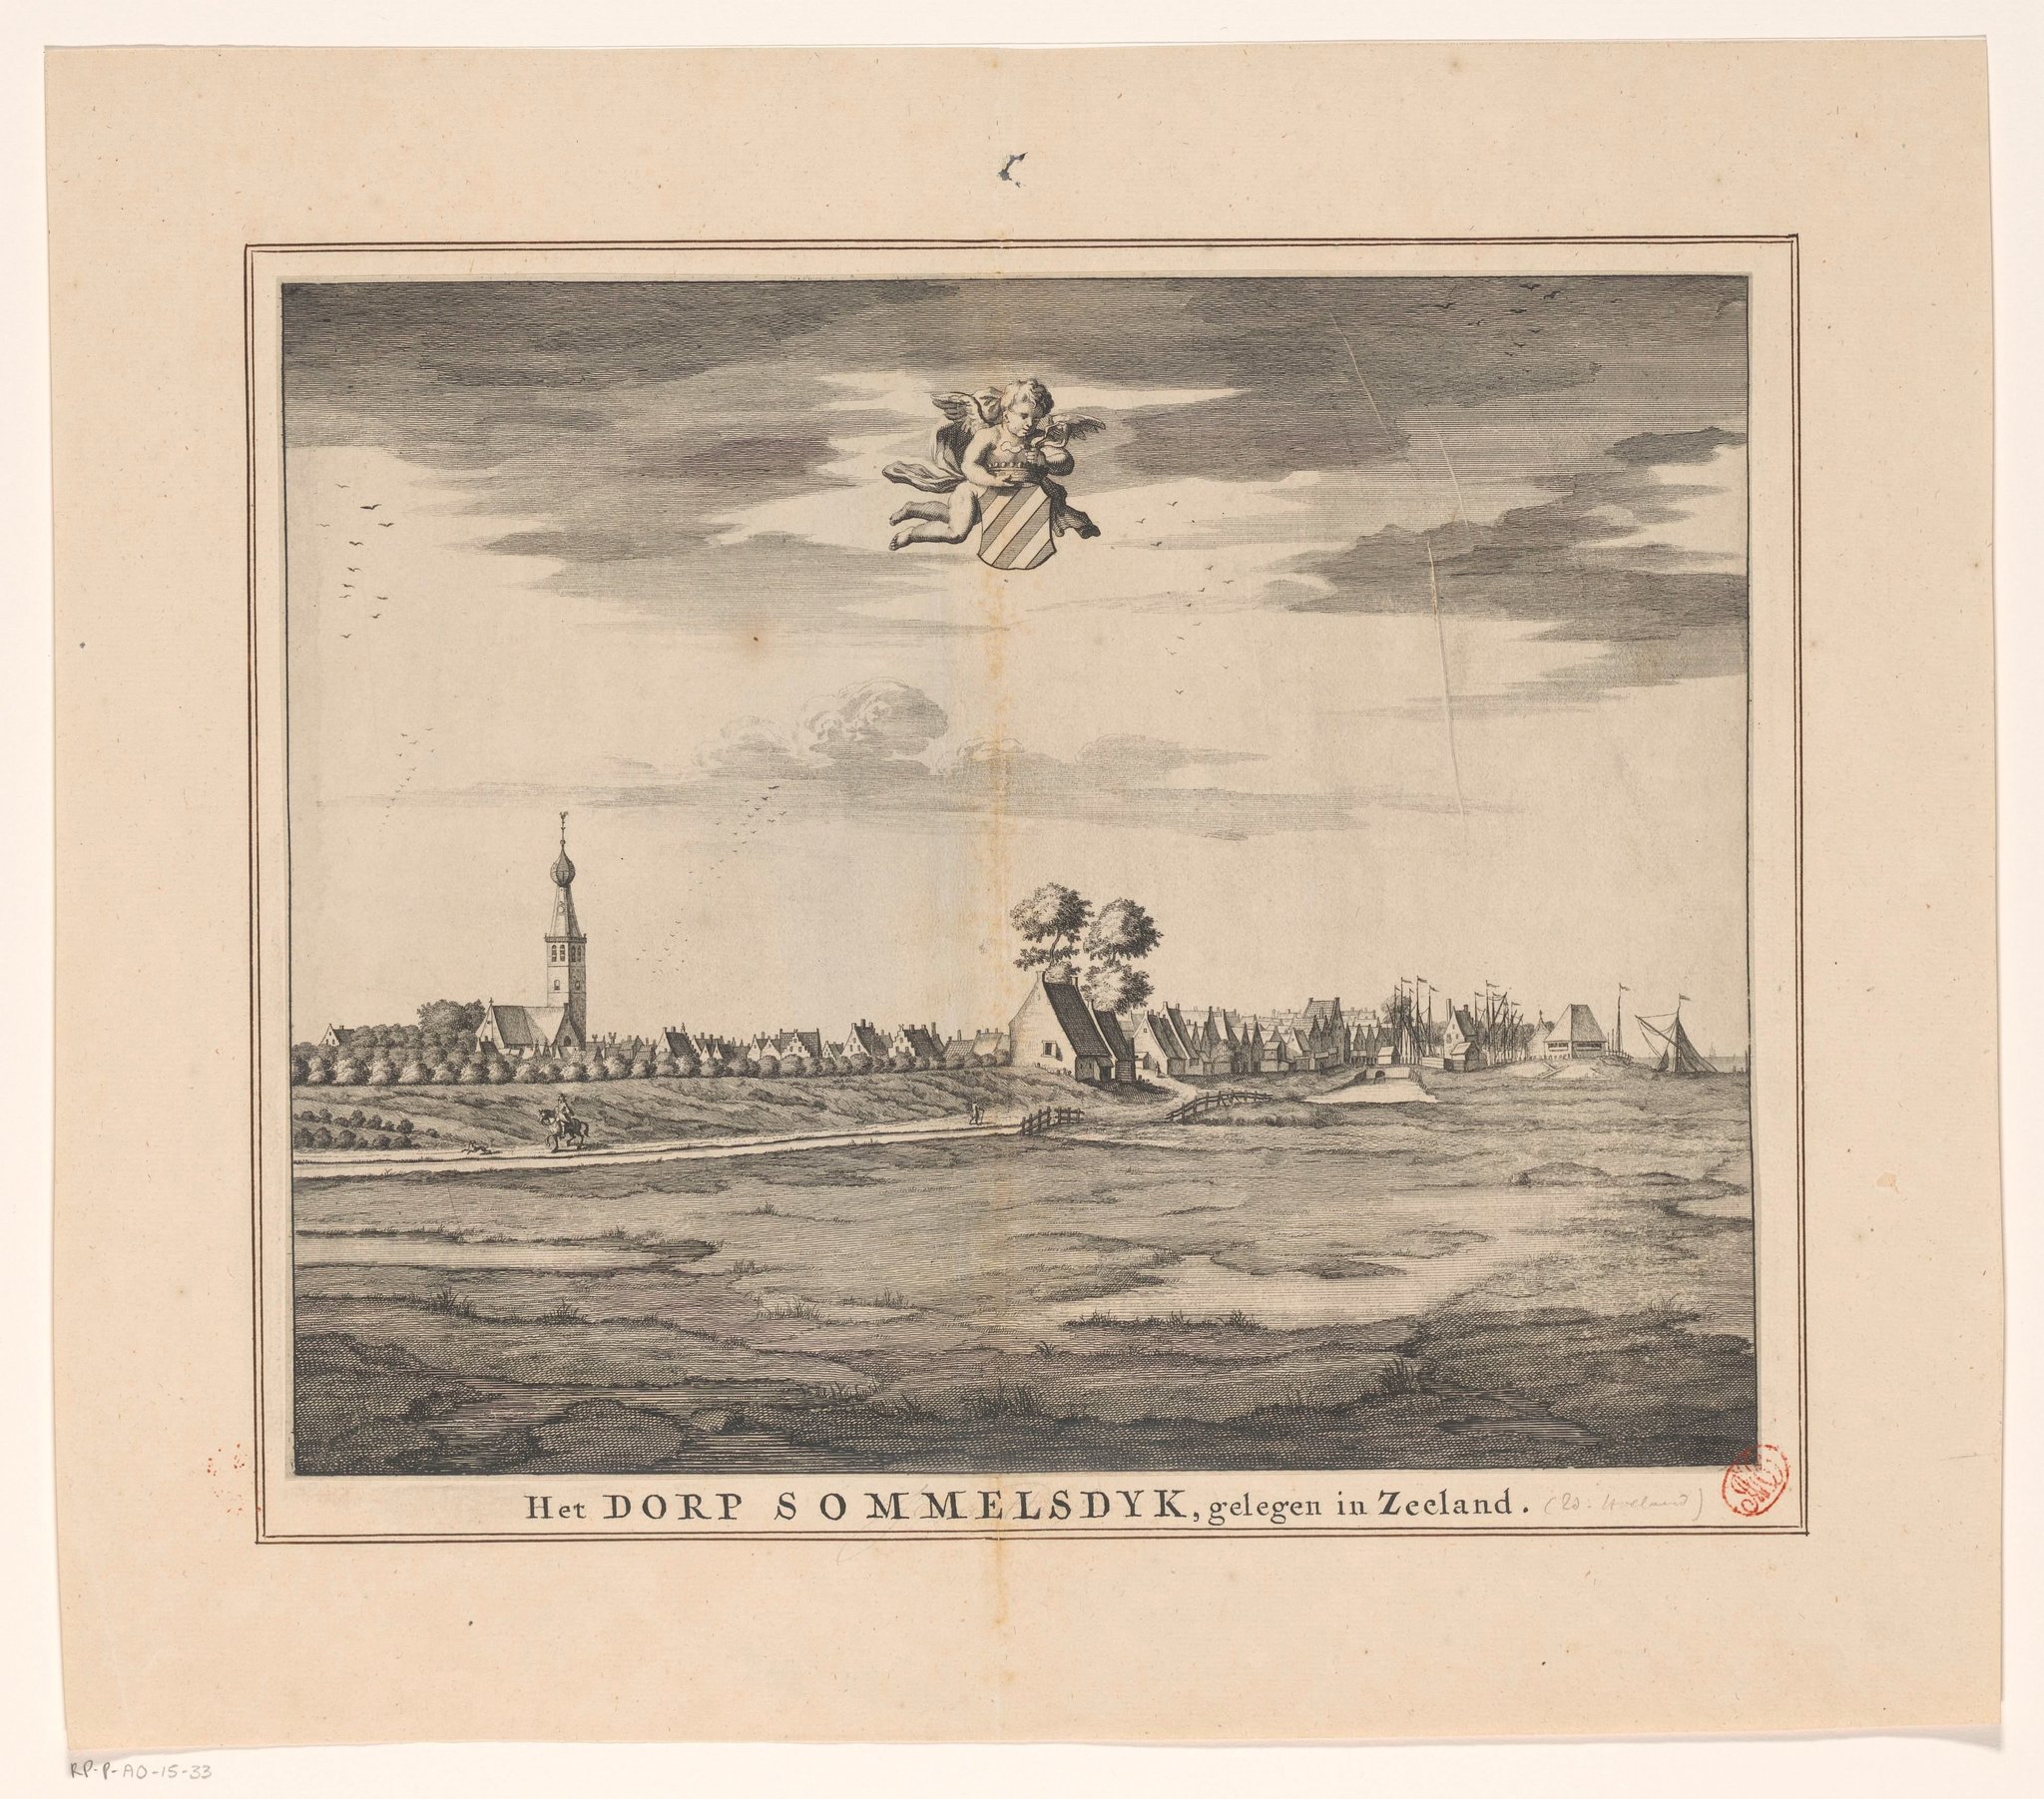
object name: print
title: Gezicht op Sommelsdijk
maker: Anonymous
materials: ink, paper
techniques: engraving, etching, pen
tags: prospect of village, silhouette of village, coat of arms (as symbol of the state, etc.) (+ city; municipal), church (exterior)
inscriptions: collector's mark: Lugt 195, inscription: ‘Het dorp Sommelsdyk, gelegen in Zeeland’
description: Latere staat of staten van prent ook gebruikt in: Smallegange, Mattheus. Nieuwe Cronyk van Zeeland (…). Middelburg en Amsterdam: Johannes Meertens en Abraham van Someren, 1696. En in: Aa, Pieter van der. La galerie agreable du monde (...). 66 delen. Leiden: Pieter van der Aa, 1728, dl. 22. Huidige staat is mogelijk een proefdruk; in tegenstelling tot de andere bekende staat er nog geen titel boven in het midden op de prent zelf.